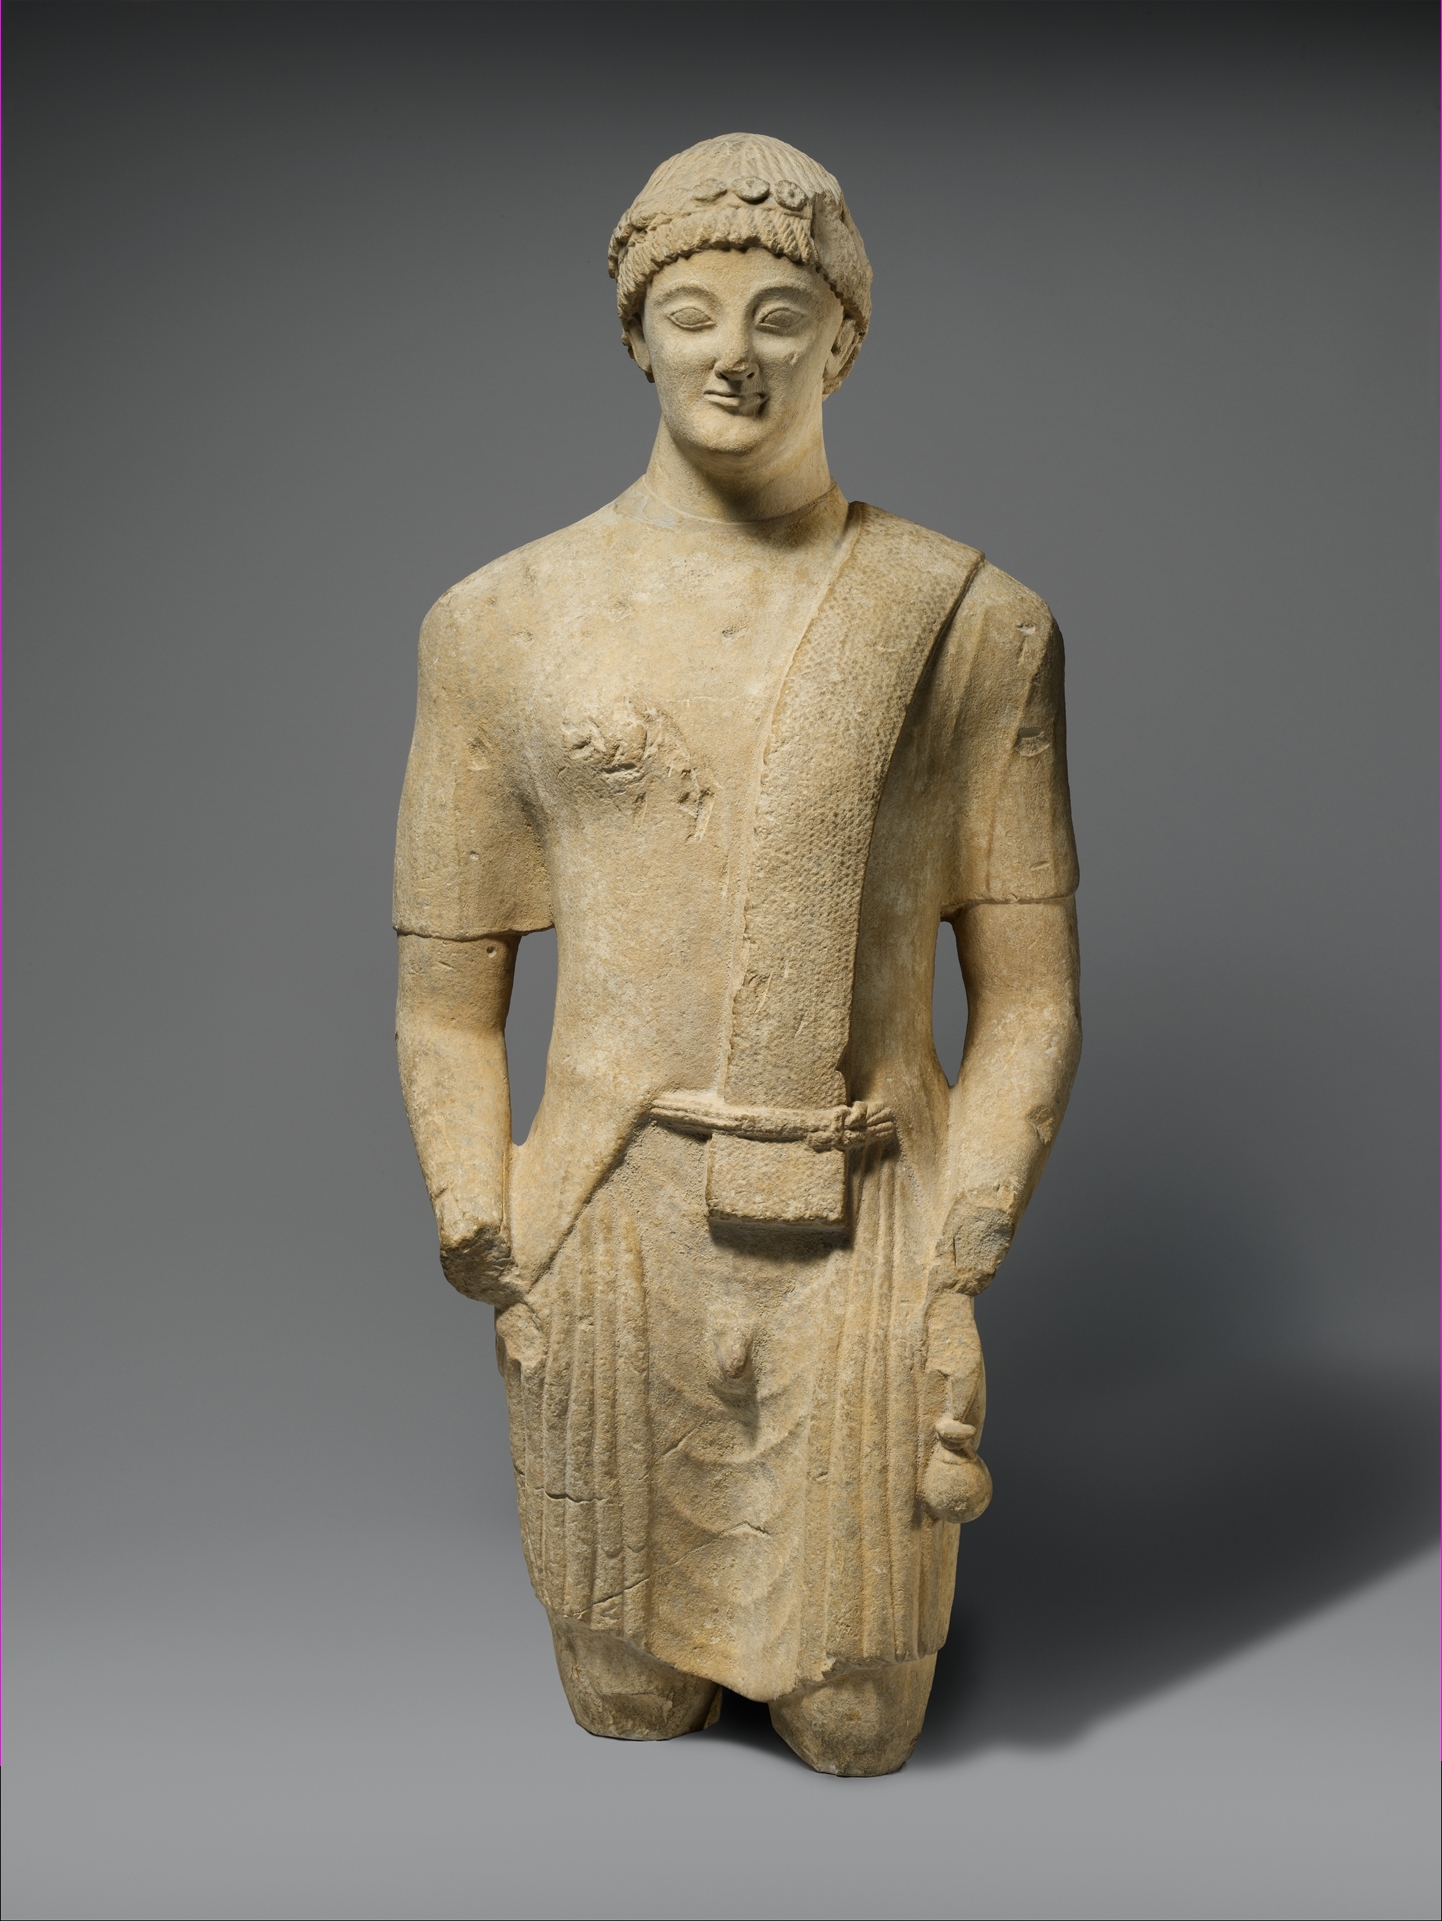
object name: statuette of a votary, male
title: Limestone statue of a male votary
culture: cypriot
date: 500-451 BCE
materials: limestone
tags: men